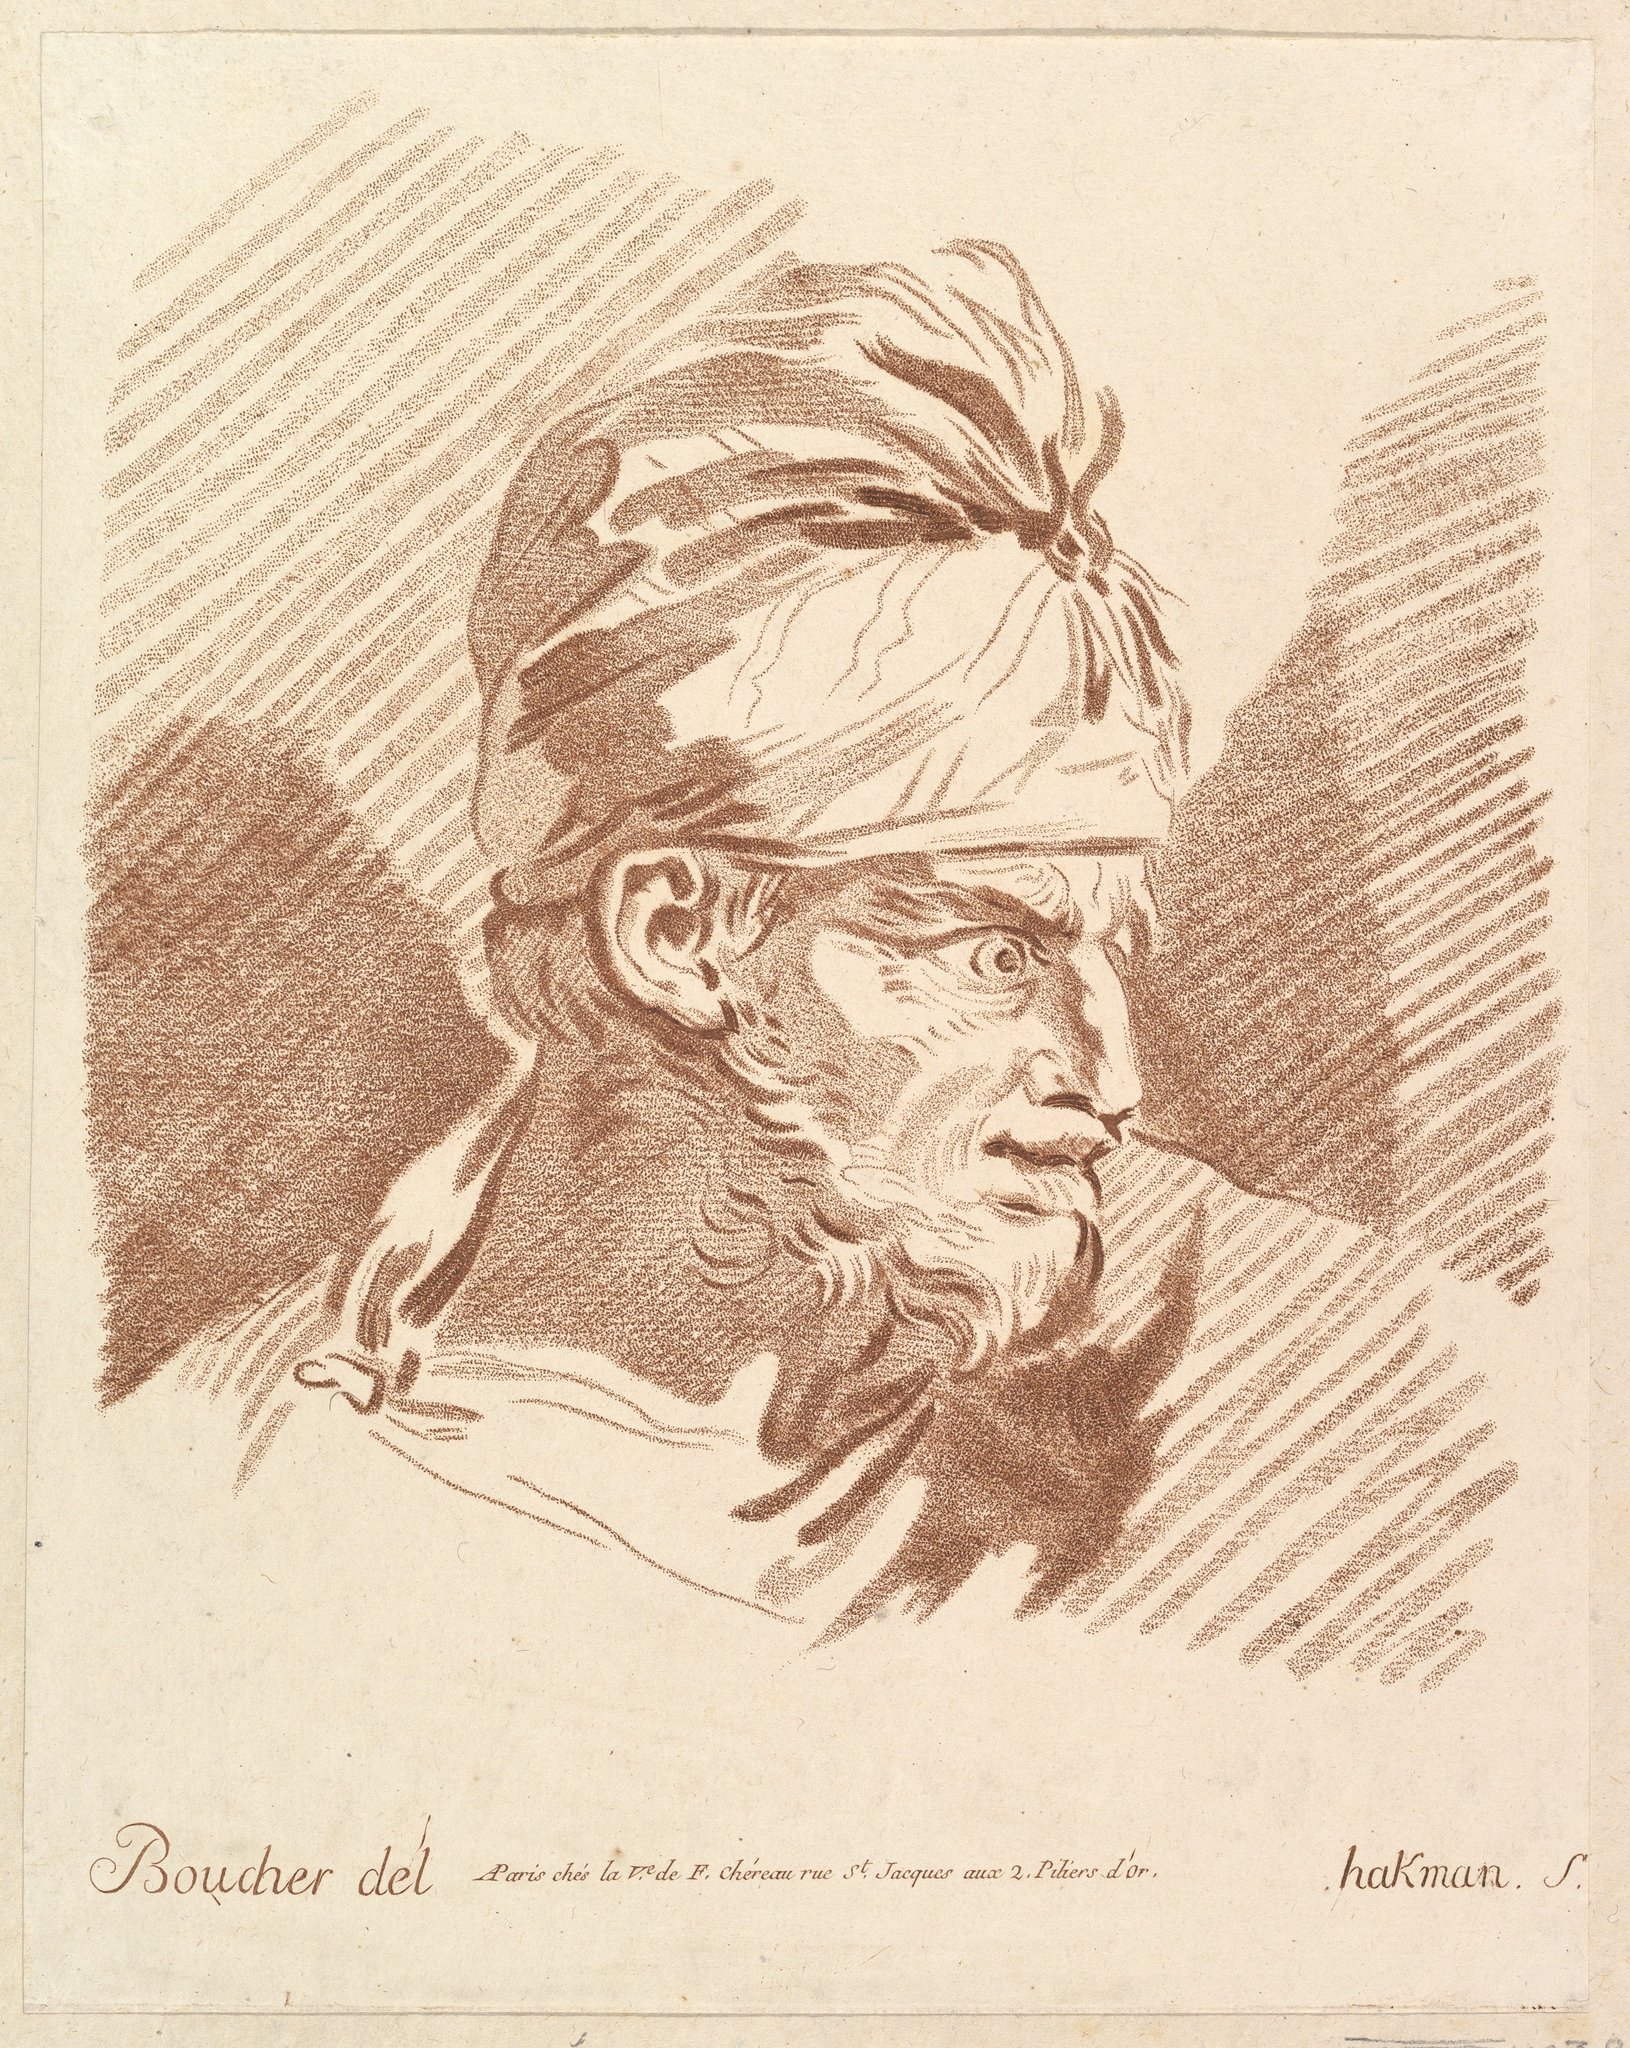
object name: print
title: Head of a Man Wearing a Turban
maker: hakman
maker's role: artist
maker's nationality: french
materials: ink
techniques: printmaking, engraving, printing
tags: men